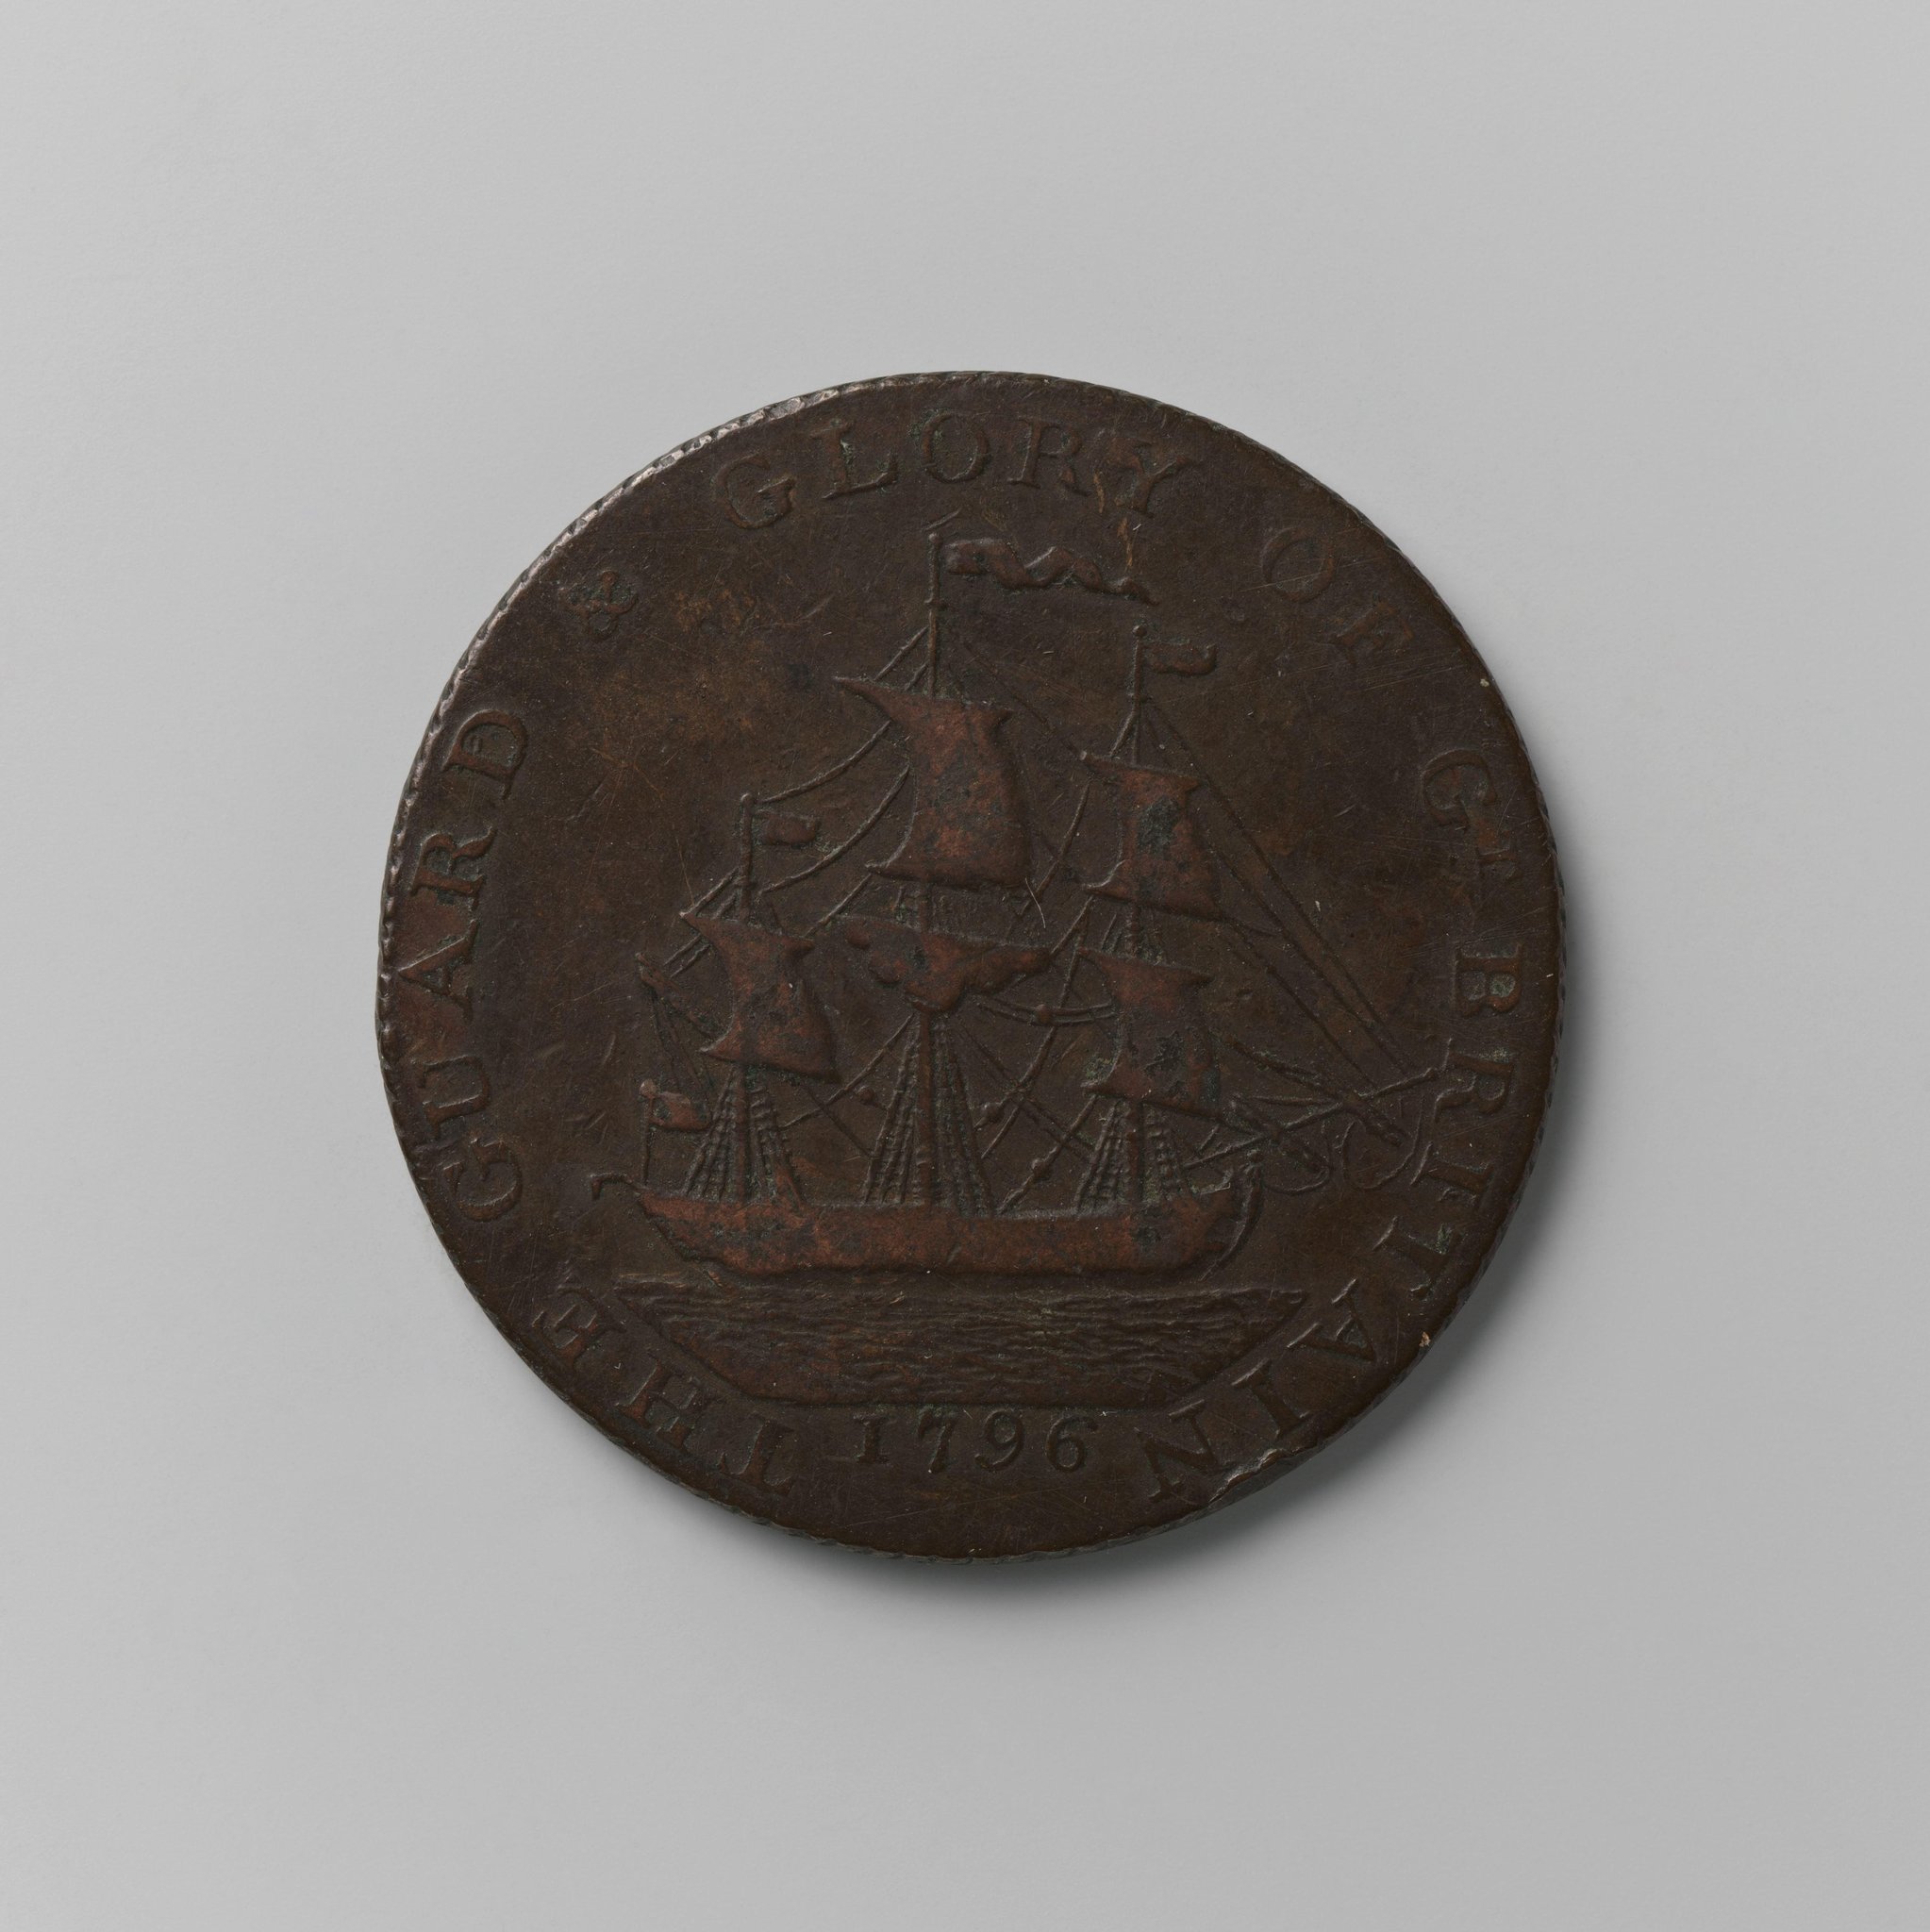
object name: halve penny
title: 1/2 penny-token, Gosport, Engeland, 1796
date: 1796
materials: copper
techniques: striking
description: Koperen particuliere munt. Voorzijde: schip met volle zeilen op zee. Jaartal onderaan. Keerzijde: staande vrouw met anker. Kabelrand.